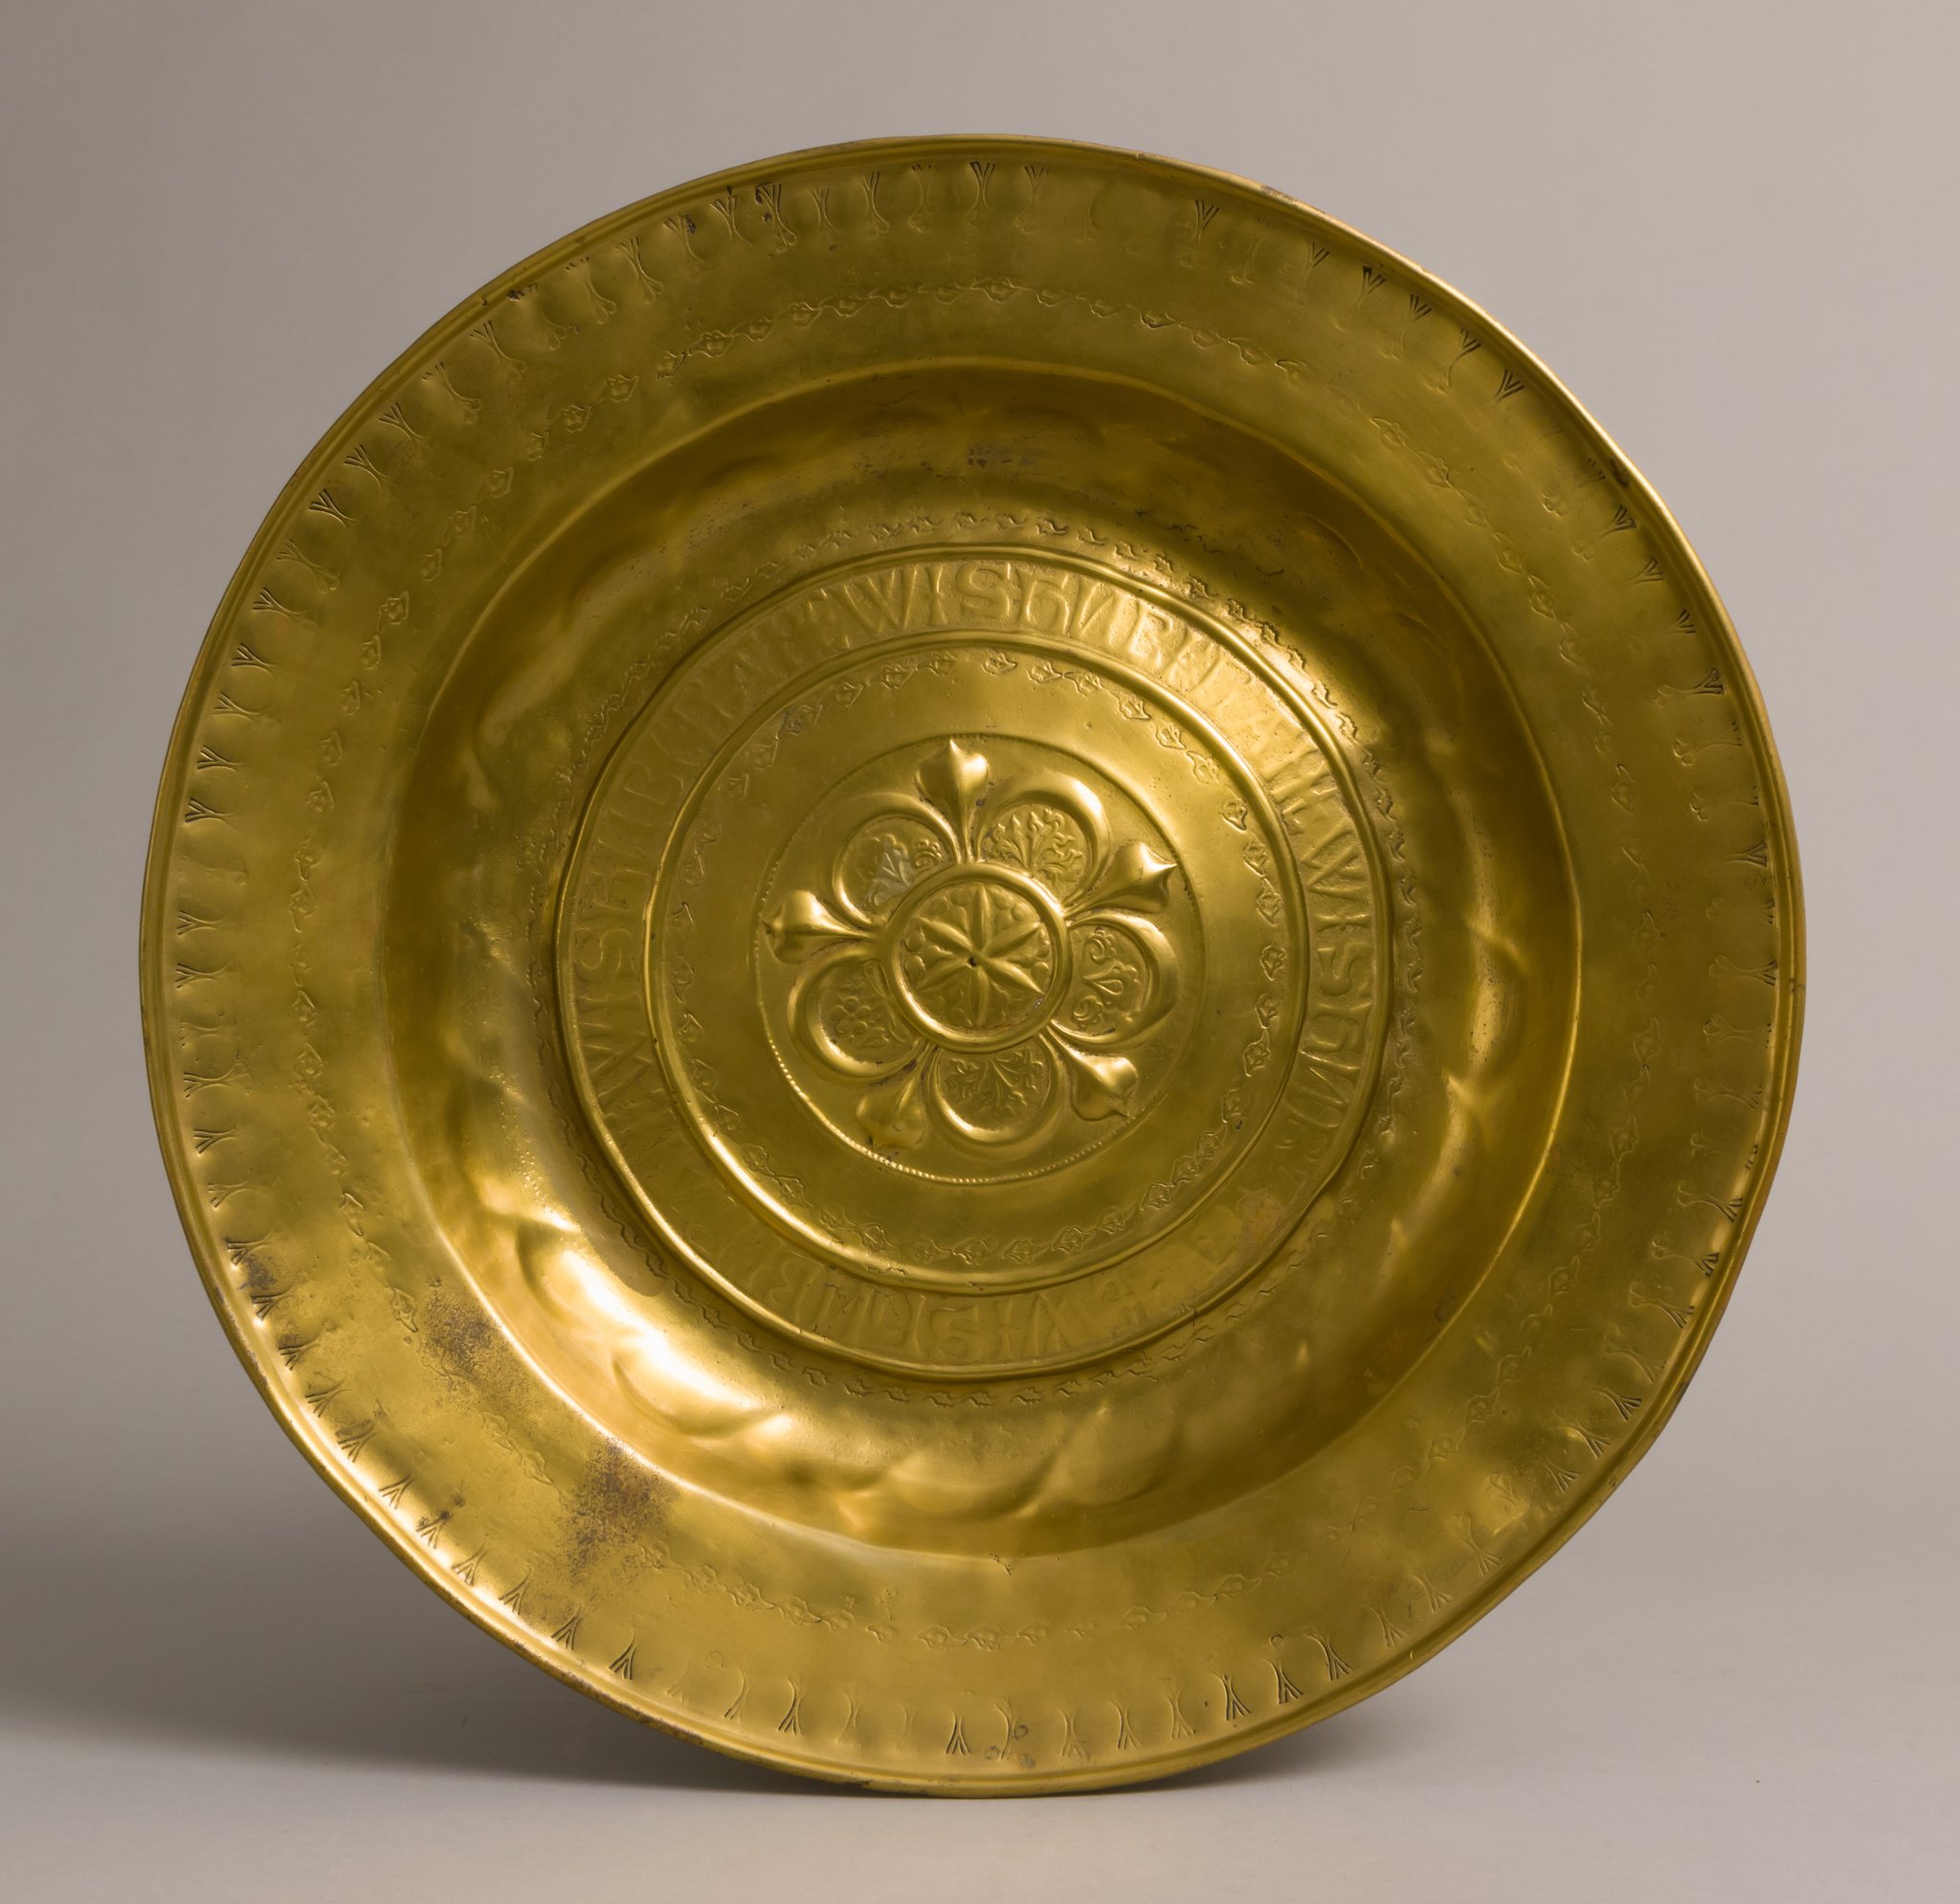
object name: dish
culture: german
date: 1501-1533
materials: brass